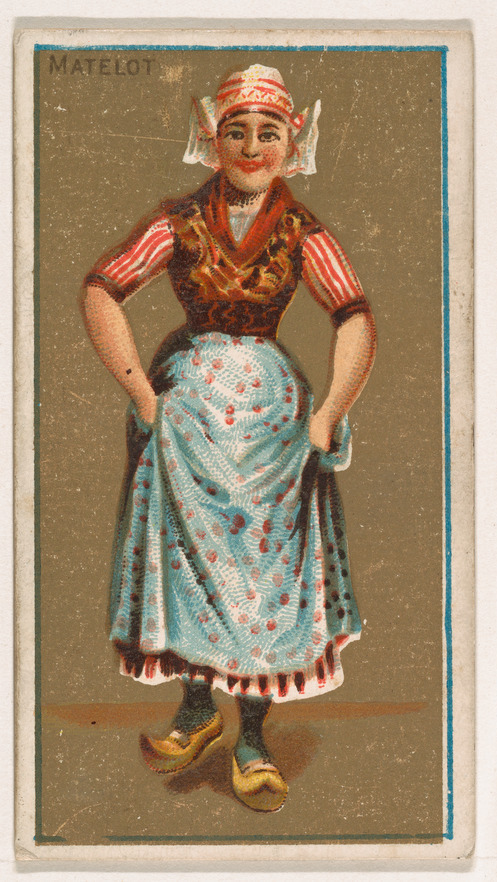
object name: print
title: Matelot, from National Dances (N225, Type 1) issued by Kinney Bros.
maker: kinney brothers tobacco company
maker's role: publisher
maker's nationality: american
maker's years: 1869-2011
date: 1889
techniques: color lithograph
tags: dance,women,dancers